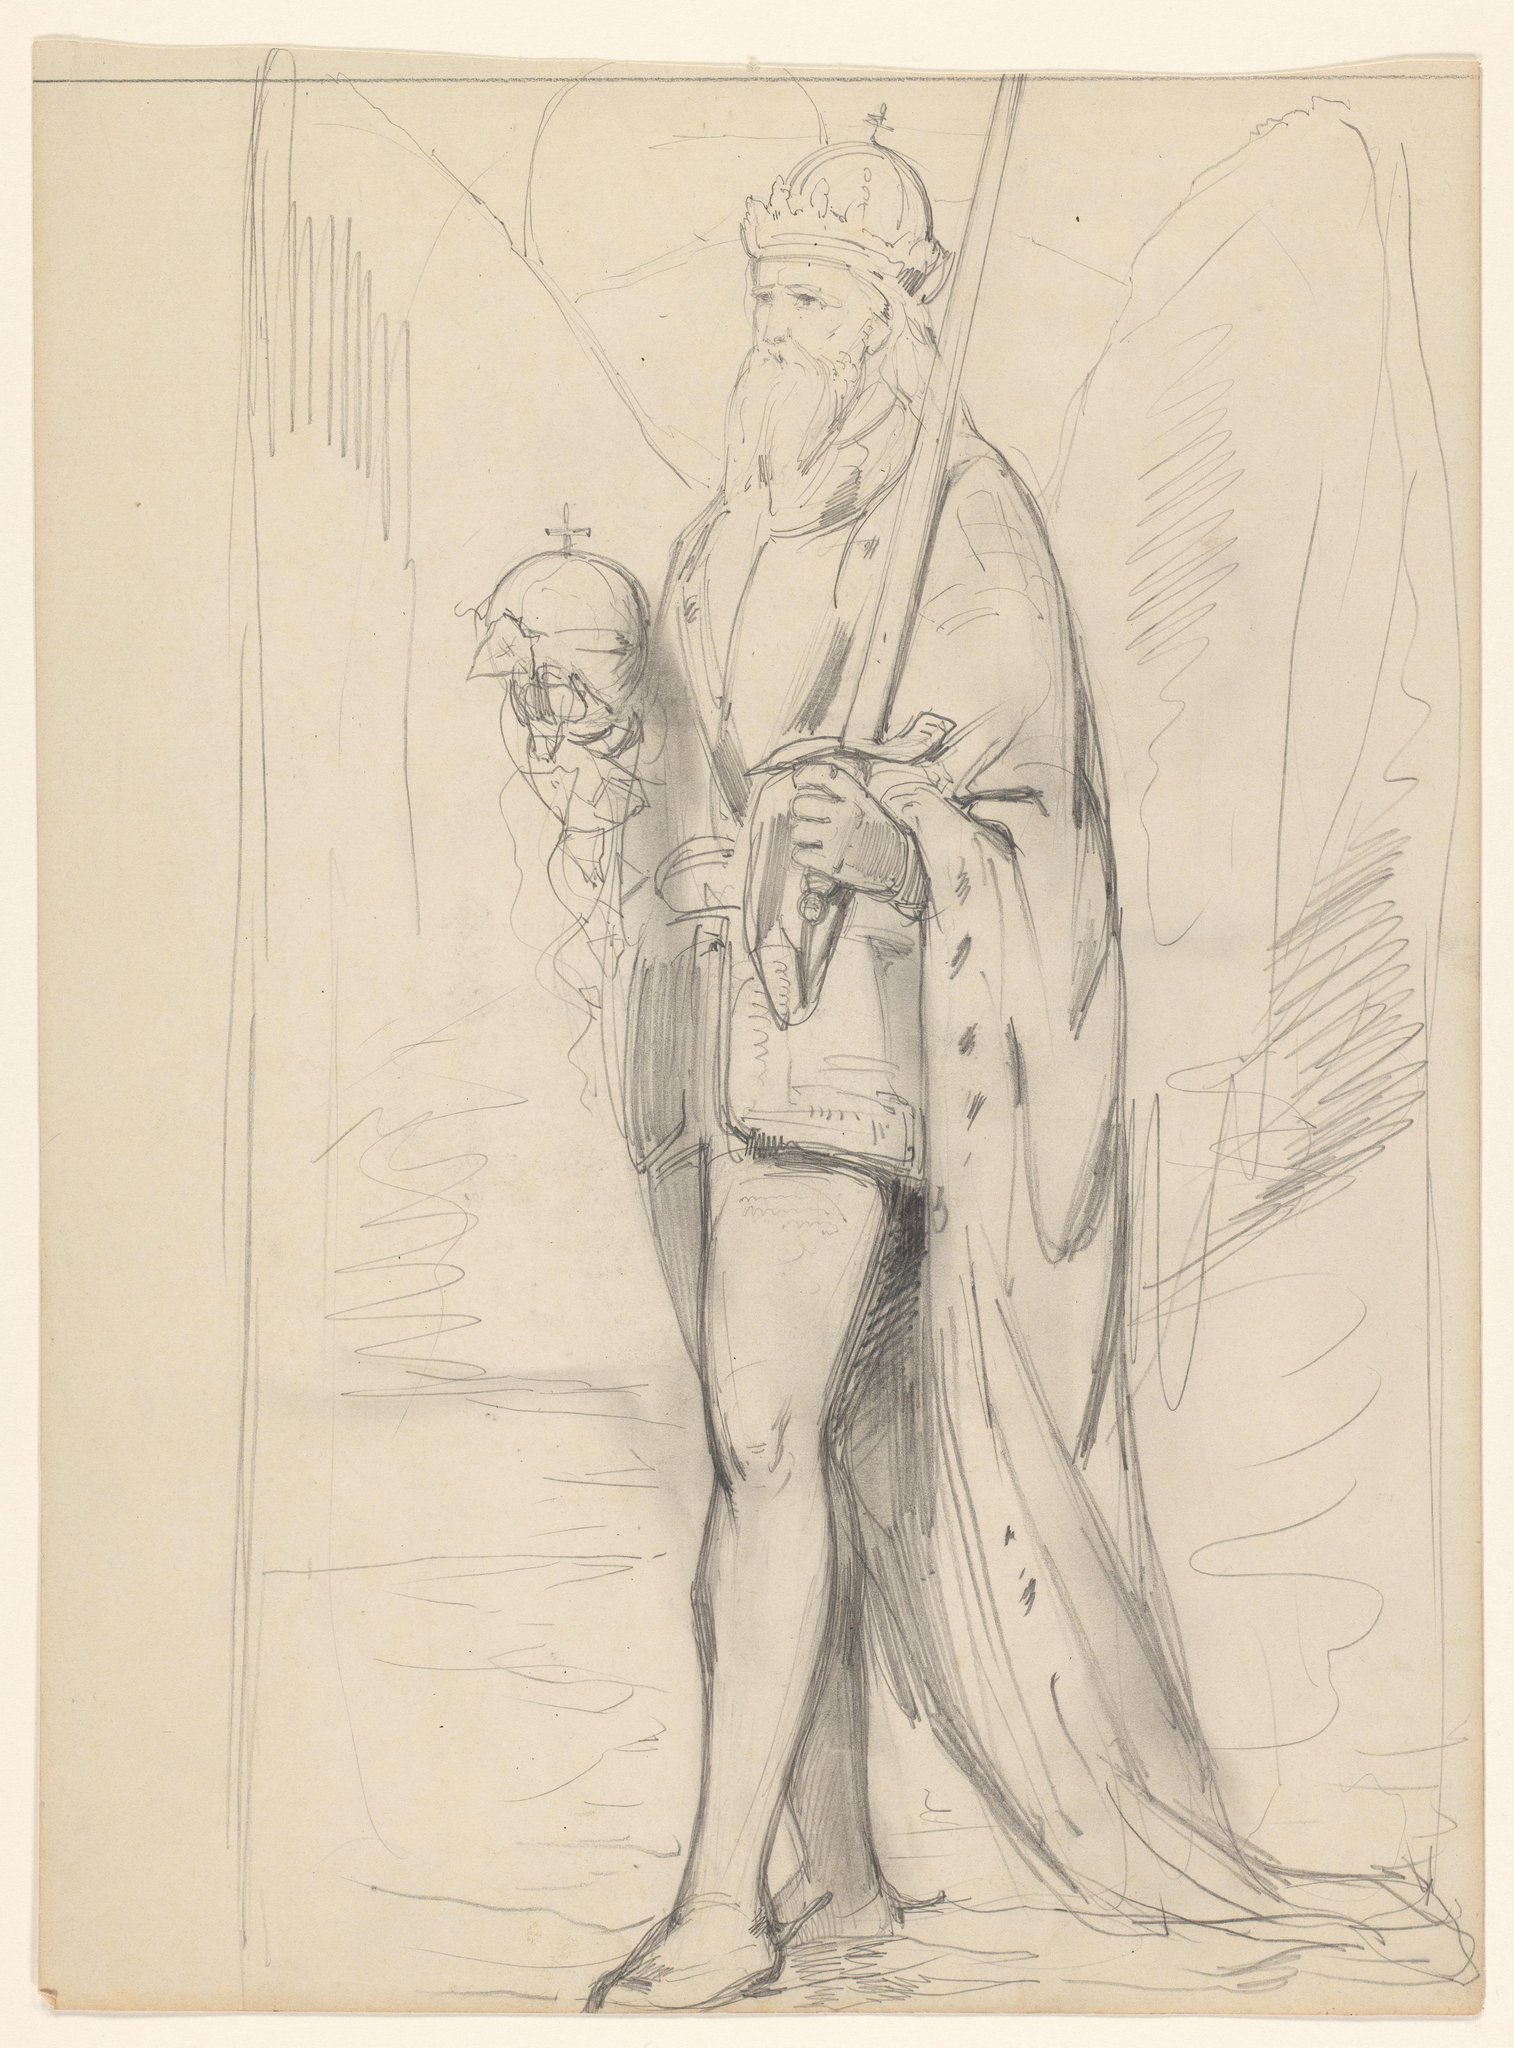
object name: drawing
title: Buffeljacht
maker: george hendrik breitner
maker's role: draughtsman, painter, print maker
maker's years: 1857-1923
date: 1874-1876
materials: paper, pencil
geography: rotterdam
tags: hoofed animals: buffalo, riding a horse, ass, or mule; rider, horseman, hunting, chase, indigenous peoples of north america, galloping horse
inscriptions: collector's mark: Lugt 2228, workshop stamp: Lugt 291d, signature: ‘G.H. Breitner’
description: Deze tekening heeft oorspronkelijk als blad 19 deel uitgemaakt van een schetsboek. Zie voor dit schetsboek het gerelateerd object.